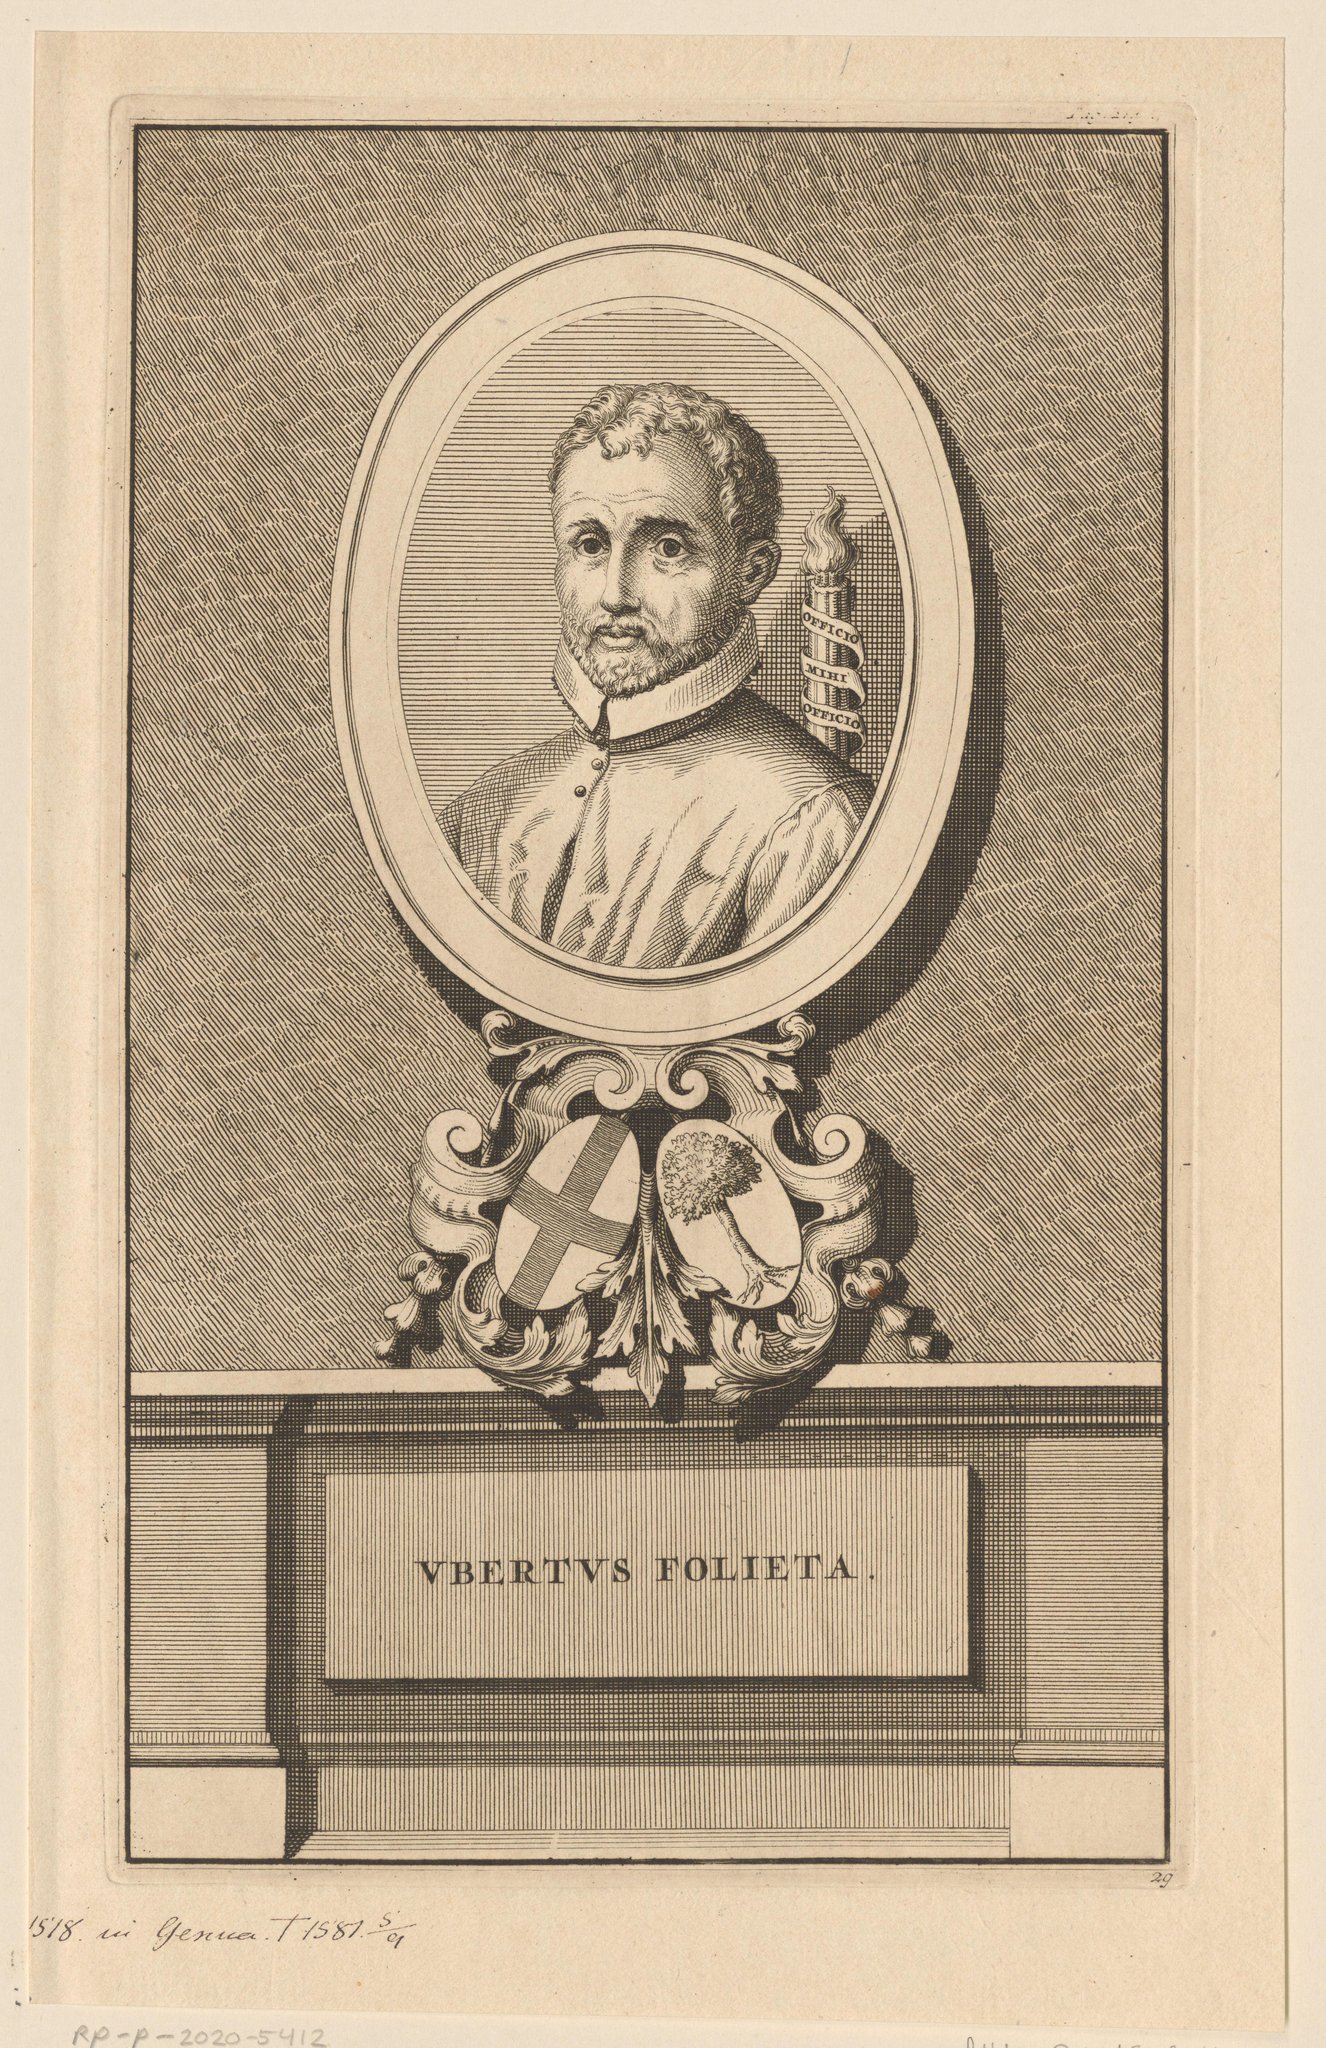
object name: print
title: Portret van Oberto Foglietta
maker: Anonymous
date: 1704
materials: paper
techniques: etching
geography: northern netherlands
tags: rome, historical persons, portrait of a writer, armorial bearing, heraldry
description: Prent in eerdere staat gebruikt in: Graevius, Joannes Georgius. Thesaurus antiquitatum et historiarum Italiae (...). Leiden: Pieter van der Aa, 1704, dl. 1-1.